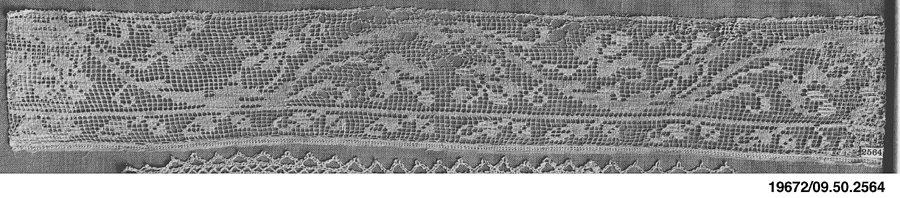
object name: strip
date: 1701-1800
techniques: embroidery